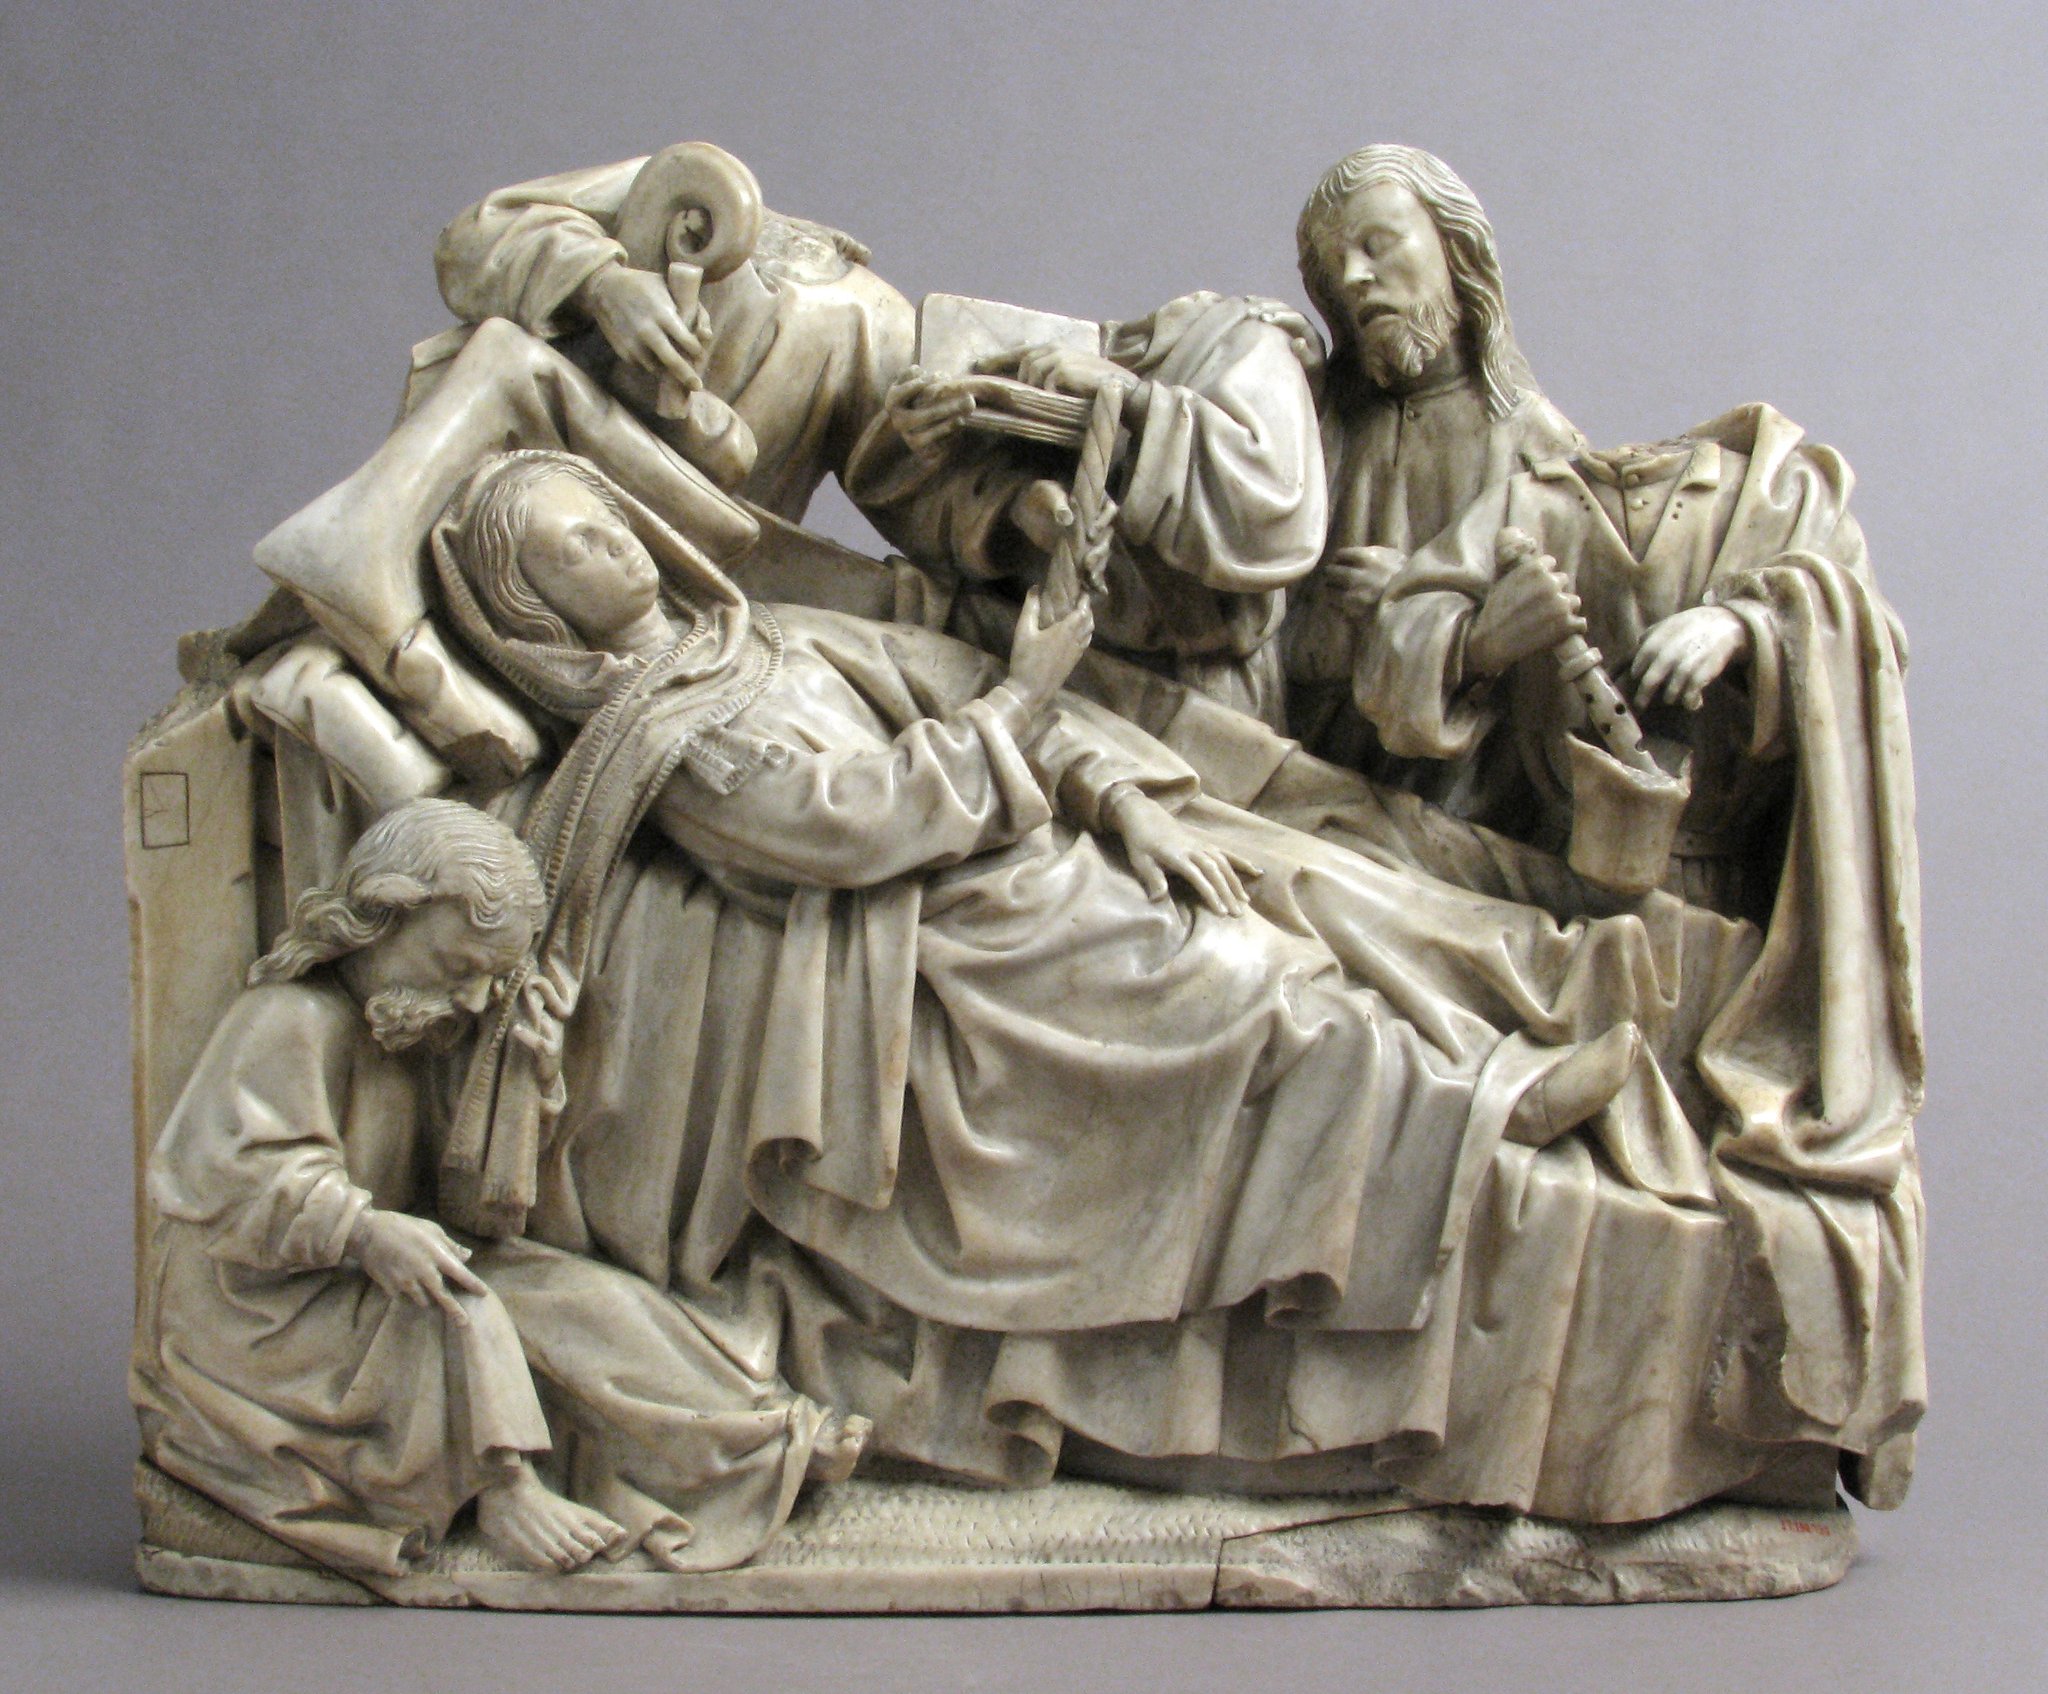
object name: wall group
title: Death of the Virgin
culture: french, north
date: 1450-1500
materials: alabaster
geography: france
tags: apostles,death